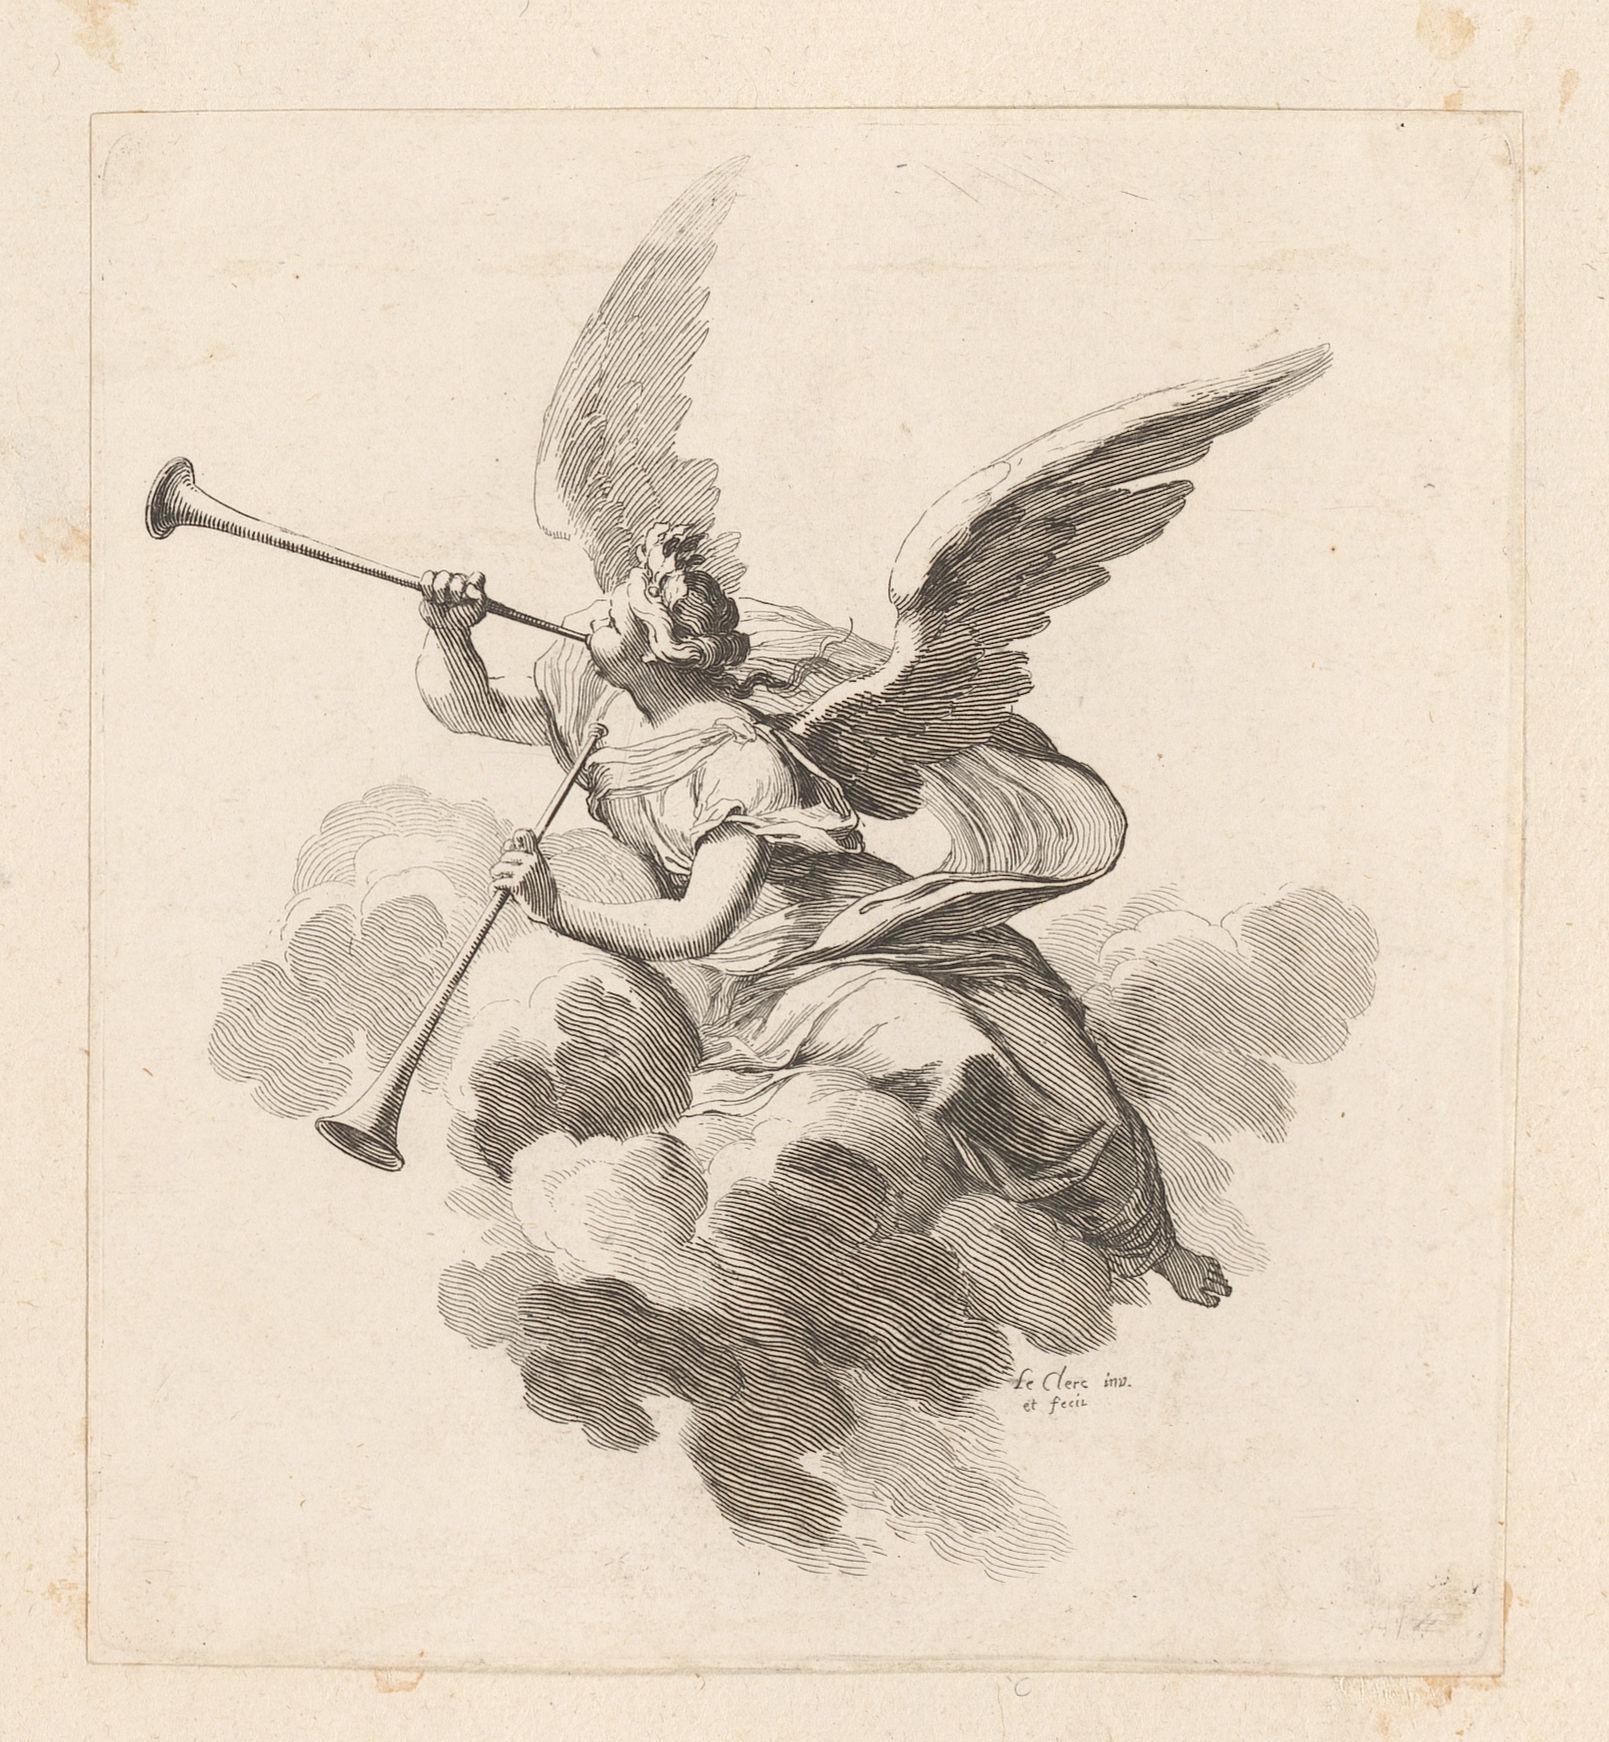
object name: album leaf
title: Cul-de-lampe met een blazoen blazende engel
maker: sébastien leclerc (i)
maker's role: print maker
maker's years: 1637-1714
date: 1670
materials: paper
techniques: etching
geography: paris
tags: fame; 'fama', 'fama buona', 'fama chiara' (ripa), angels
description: Prent uit: Félibien, André. Tapisseries du Roi, où sont représentez les quatre élémens et les quatre saisons. Parijs: Imprimerie Royale, 1670.